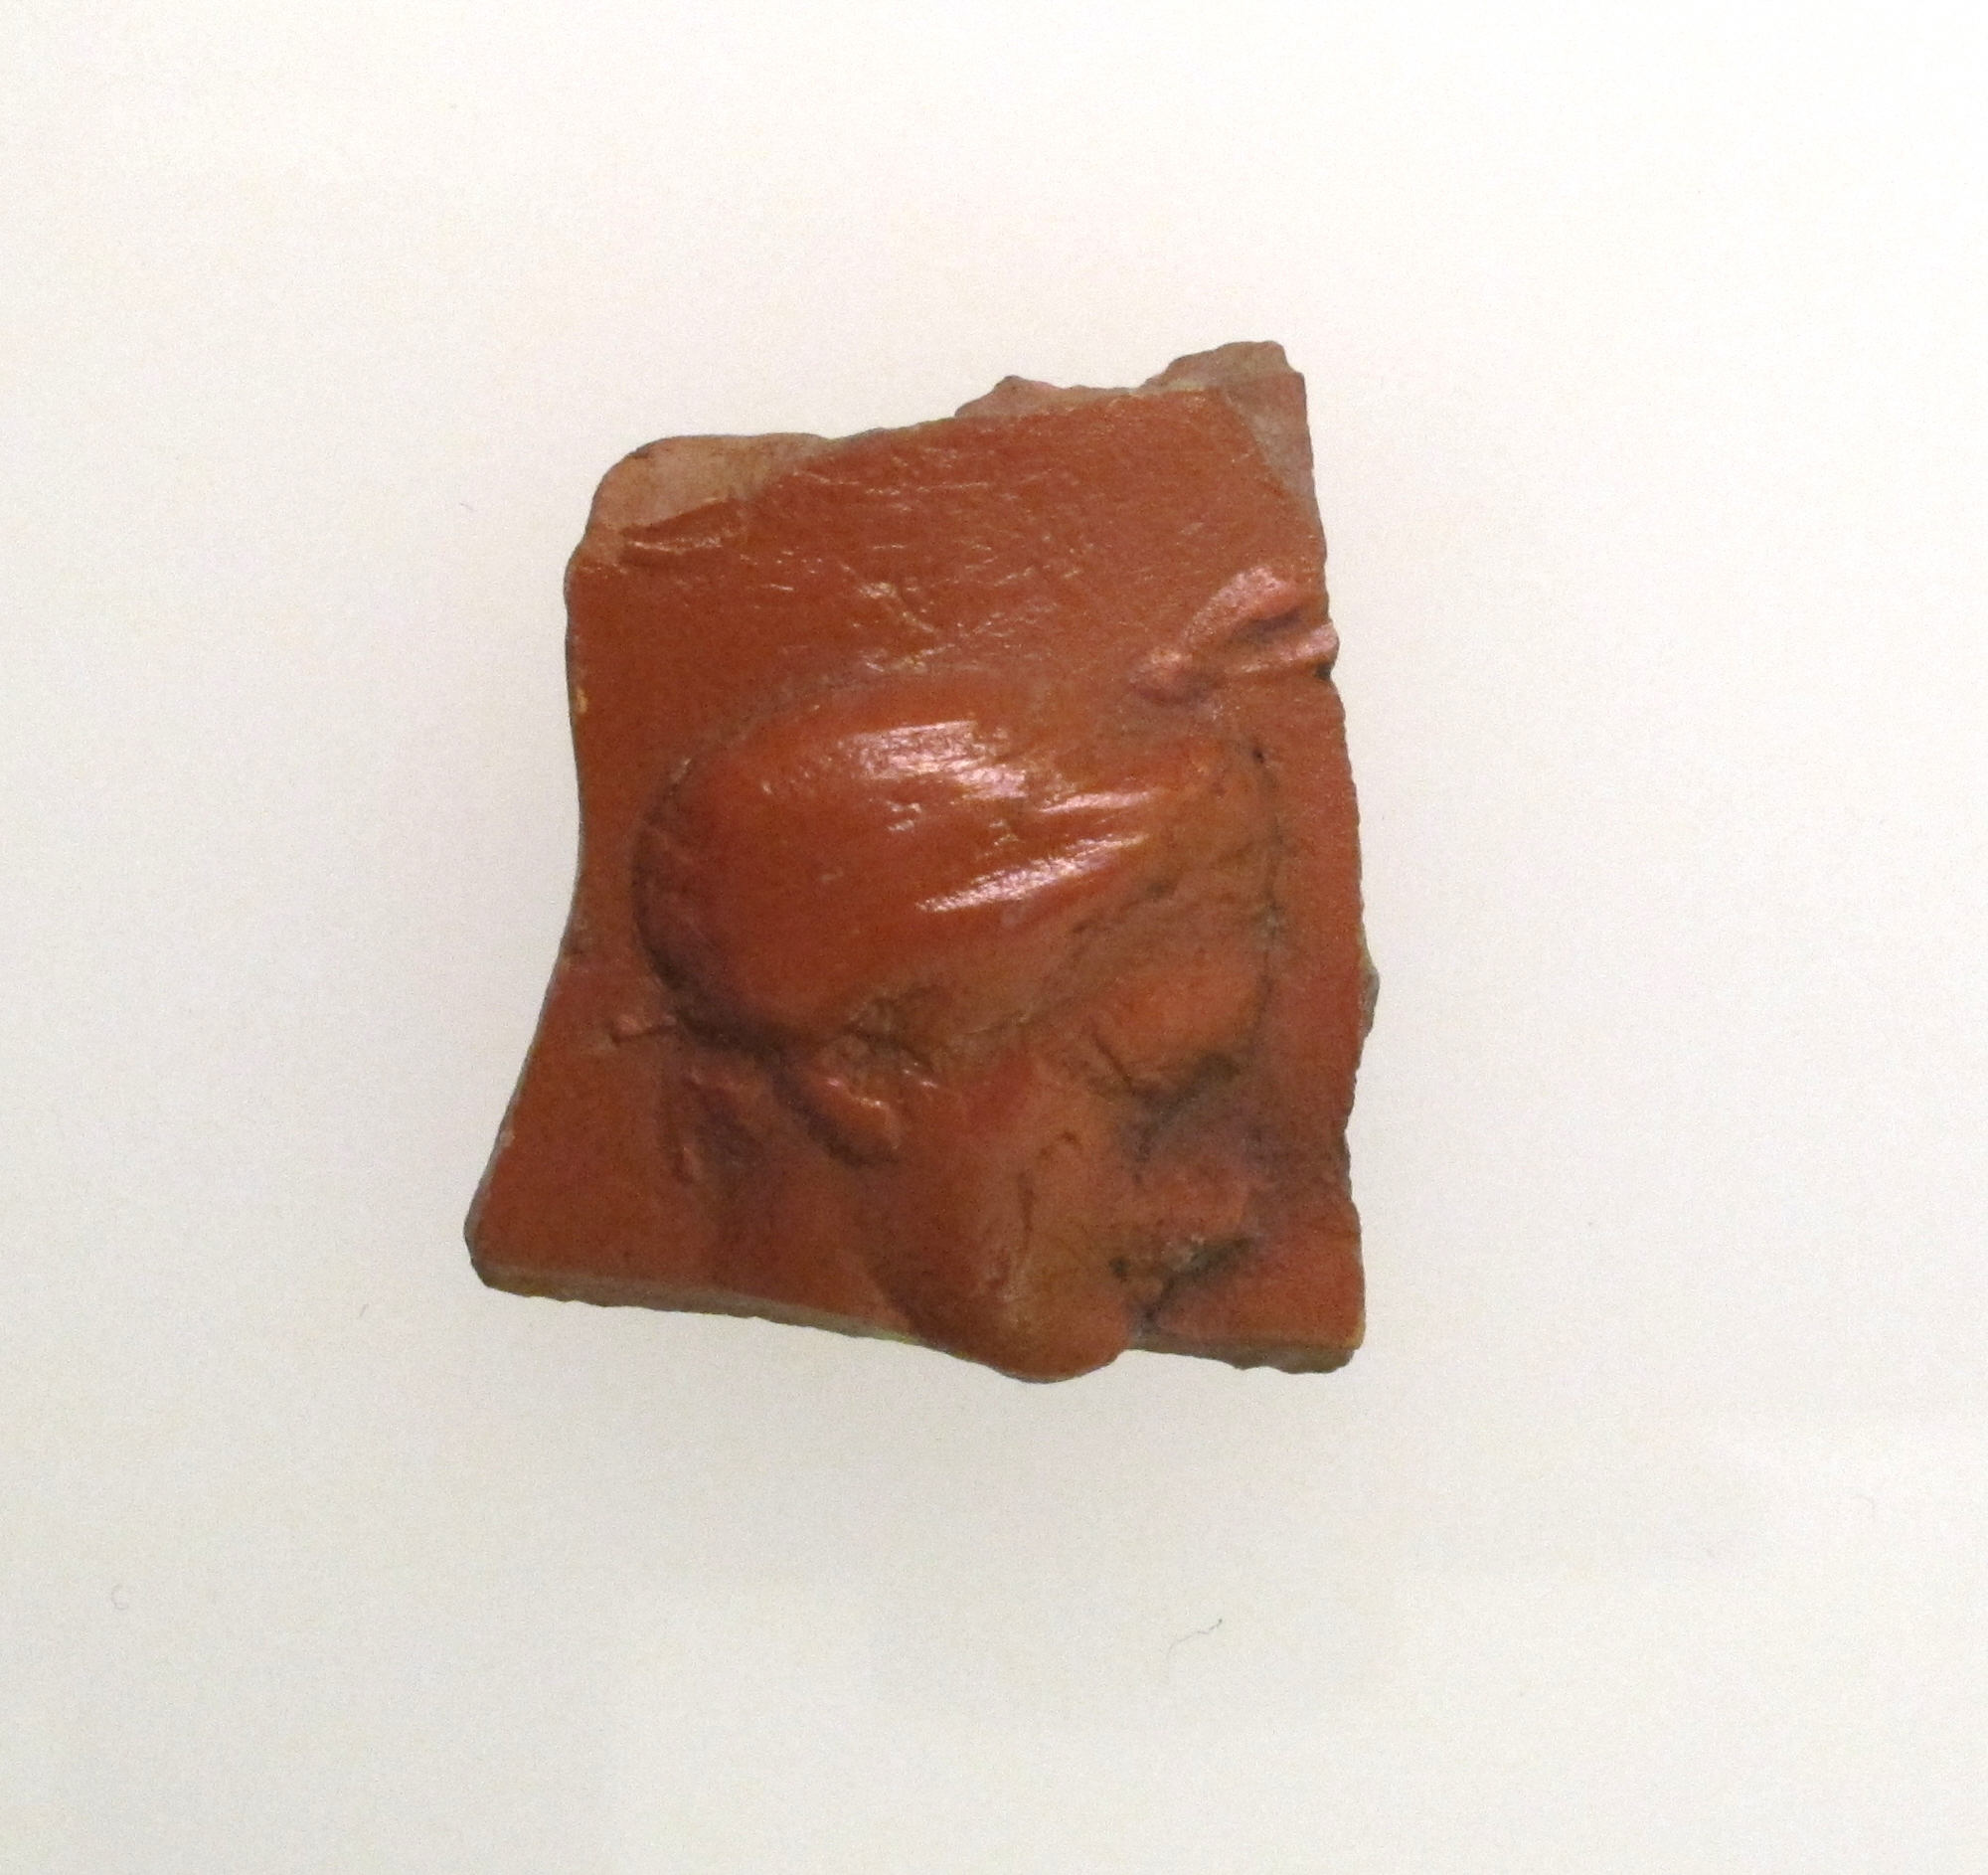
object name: vase fragment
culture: roman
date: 670 BCE-330 CE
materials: terracotta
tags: heads